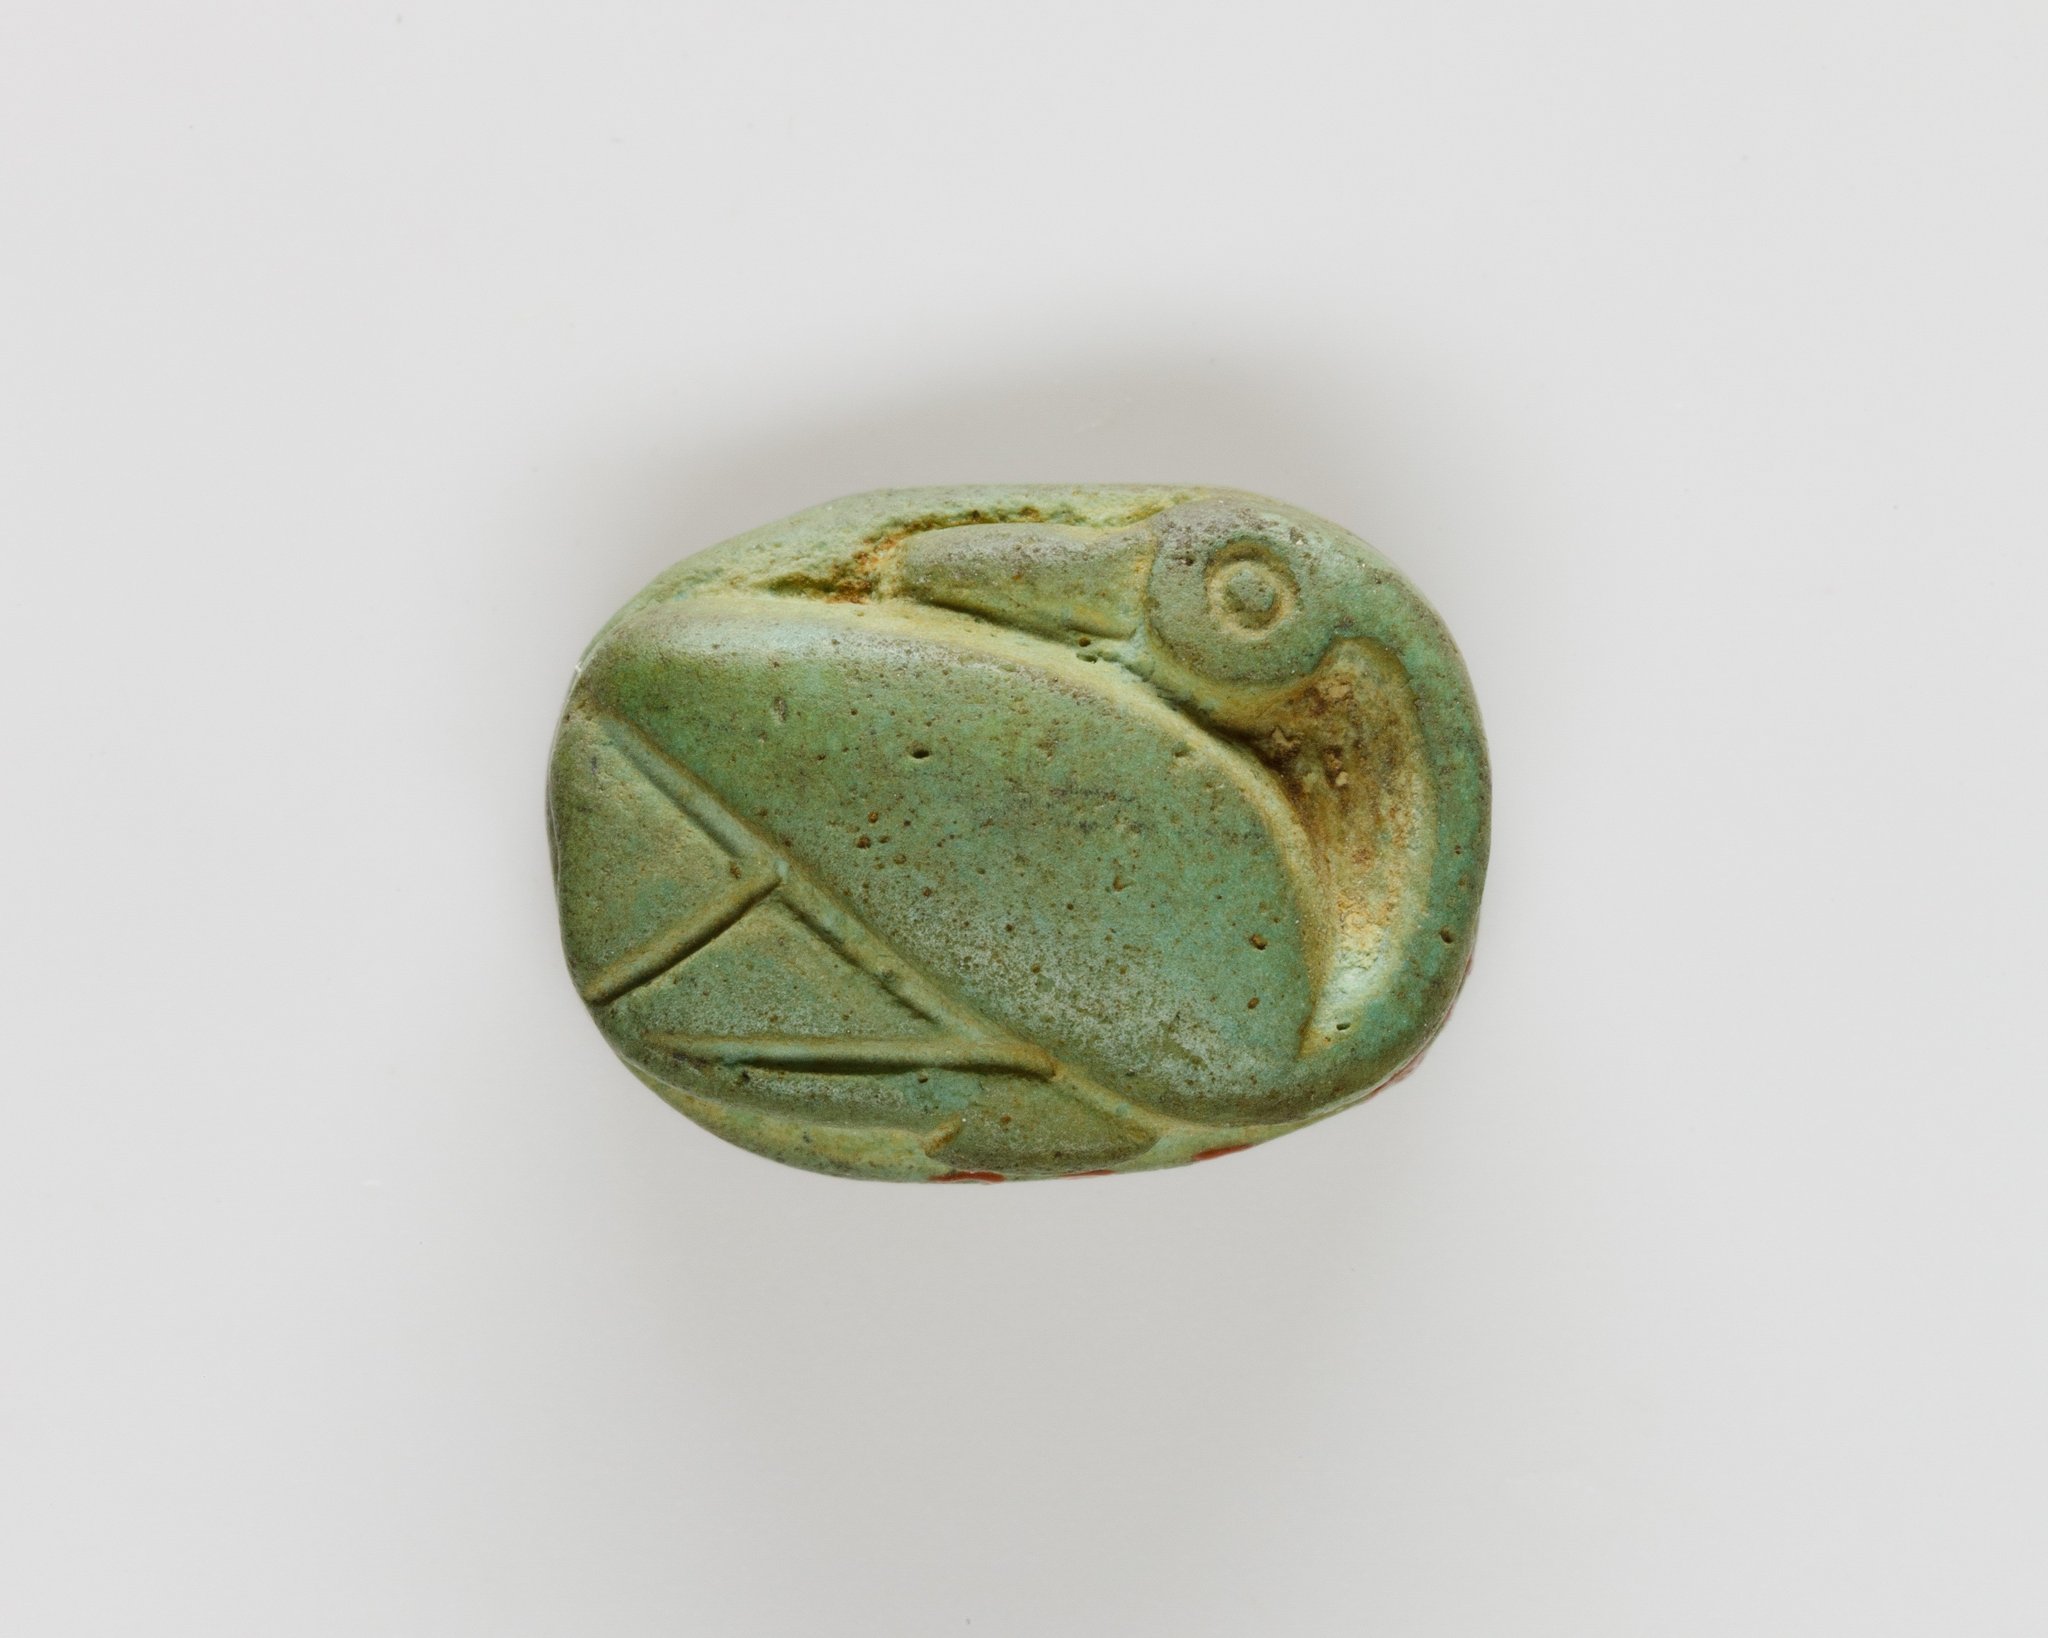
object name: seal plaque, duck, lotus and bud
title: Plaque Decorated with a Duck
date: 1492-1473 BCE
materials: stone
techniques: glazing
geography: egypt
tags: ducks